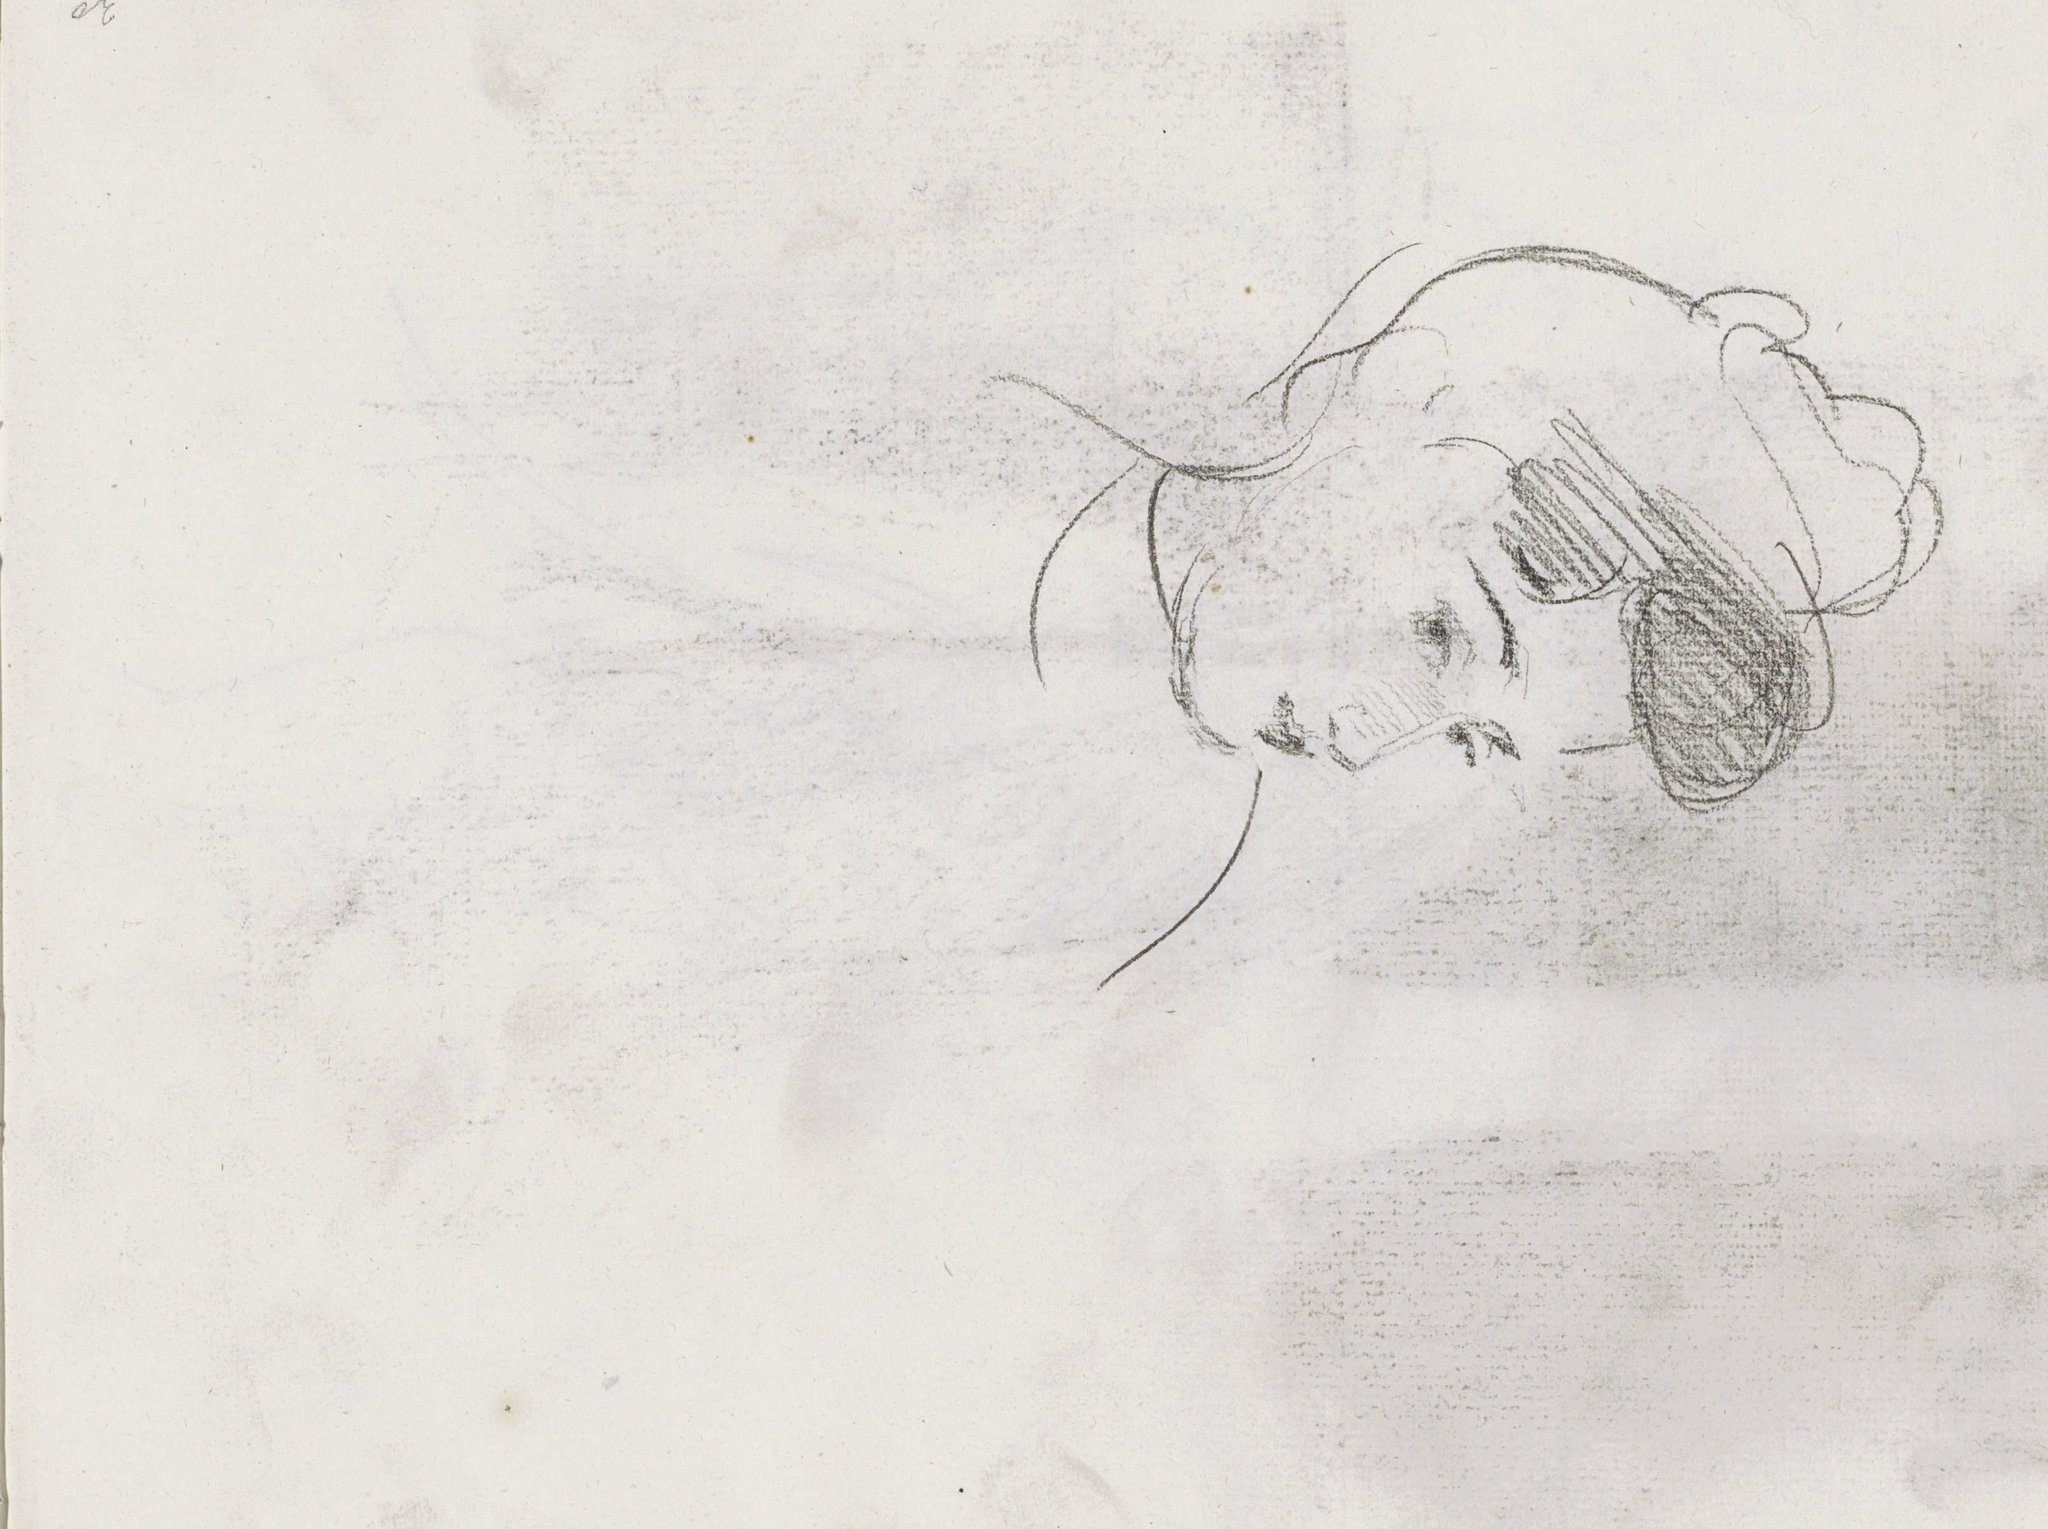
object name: sketchbook leaf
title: Vrouwenhoofd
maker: isaac israels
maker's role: draughtsman, painter, print maker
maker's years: 1865-1934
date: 1875-1934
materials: chalk, paper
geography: the hague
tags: head (human) - aa - female human figure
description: Blad 12 recto uit schetsboek XXII met 30 bladen.